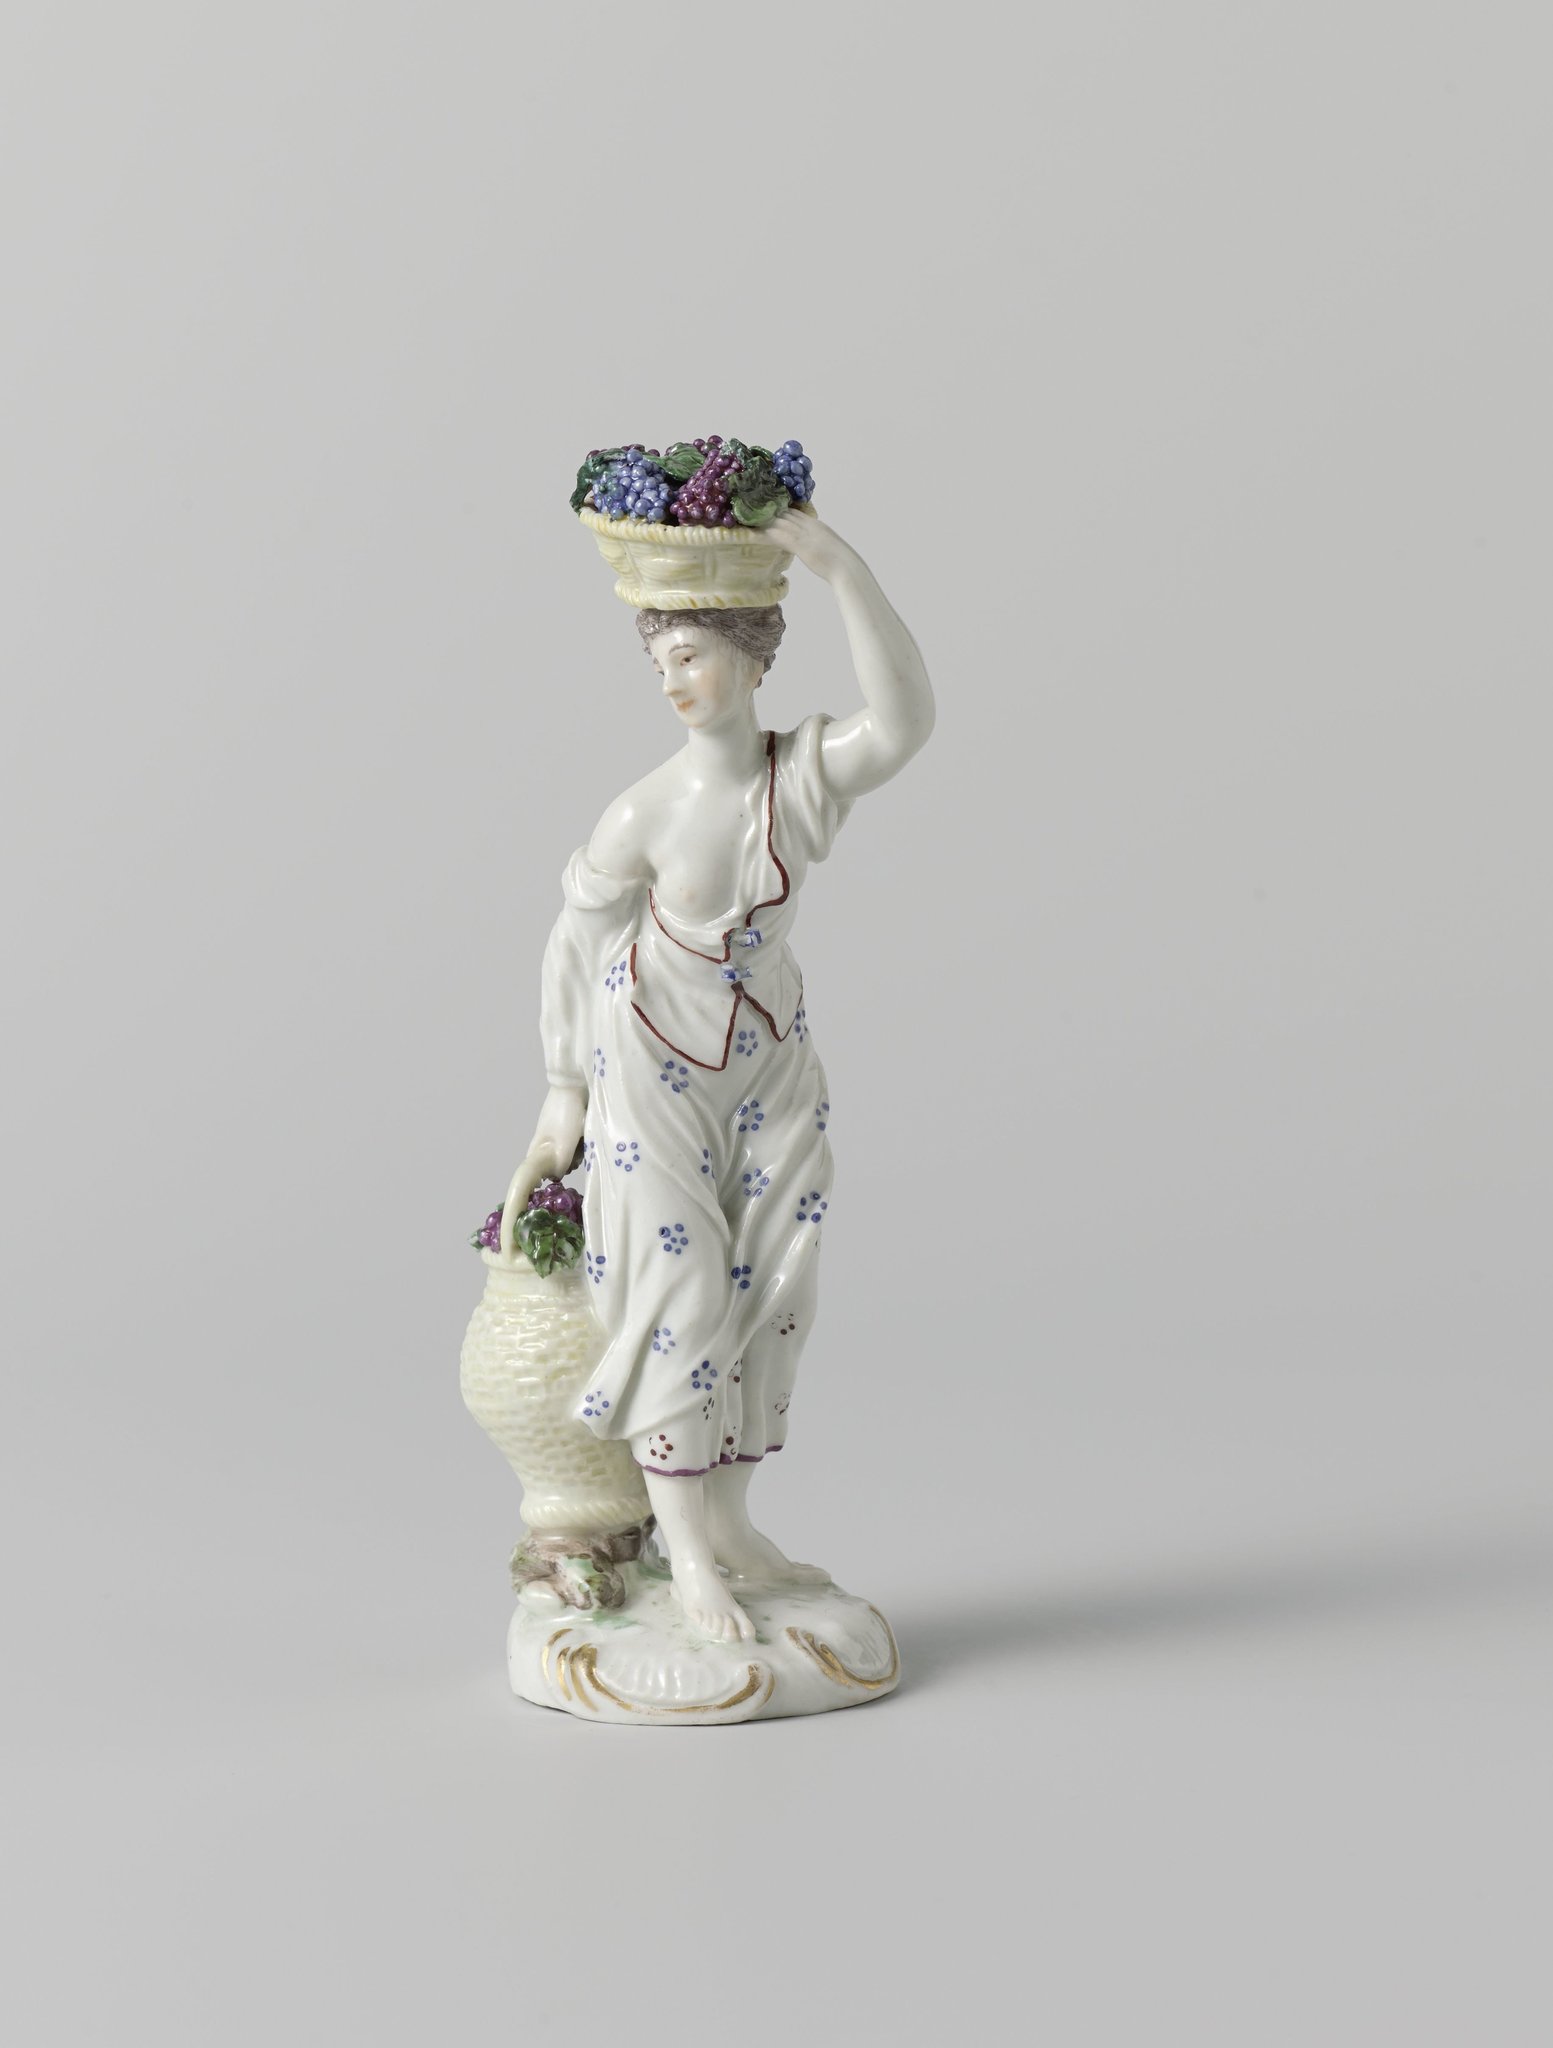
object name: figure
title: Figure of a woman with baskets filled with grapes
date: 1765-1770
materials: glaze, gold, paint, porcelain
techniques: firing, forming, gilding, vitrification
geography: ludwigsburg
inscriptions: mark: ‘gekroonde dubbele C’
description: A woman picking grapes. Porcelain. Ludwigsburg, c. 1765 - 1770, model attributed to Jean Jacques Louis,